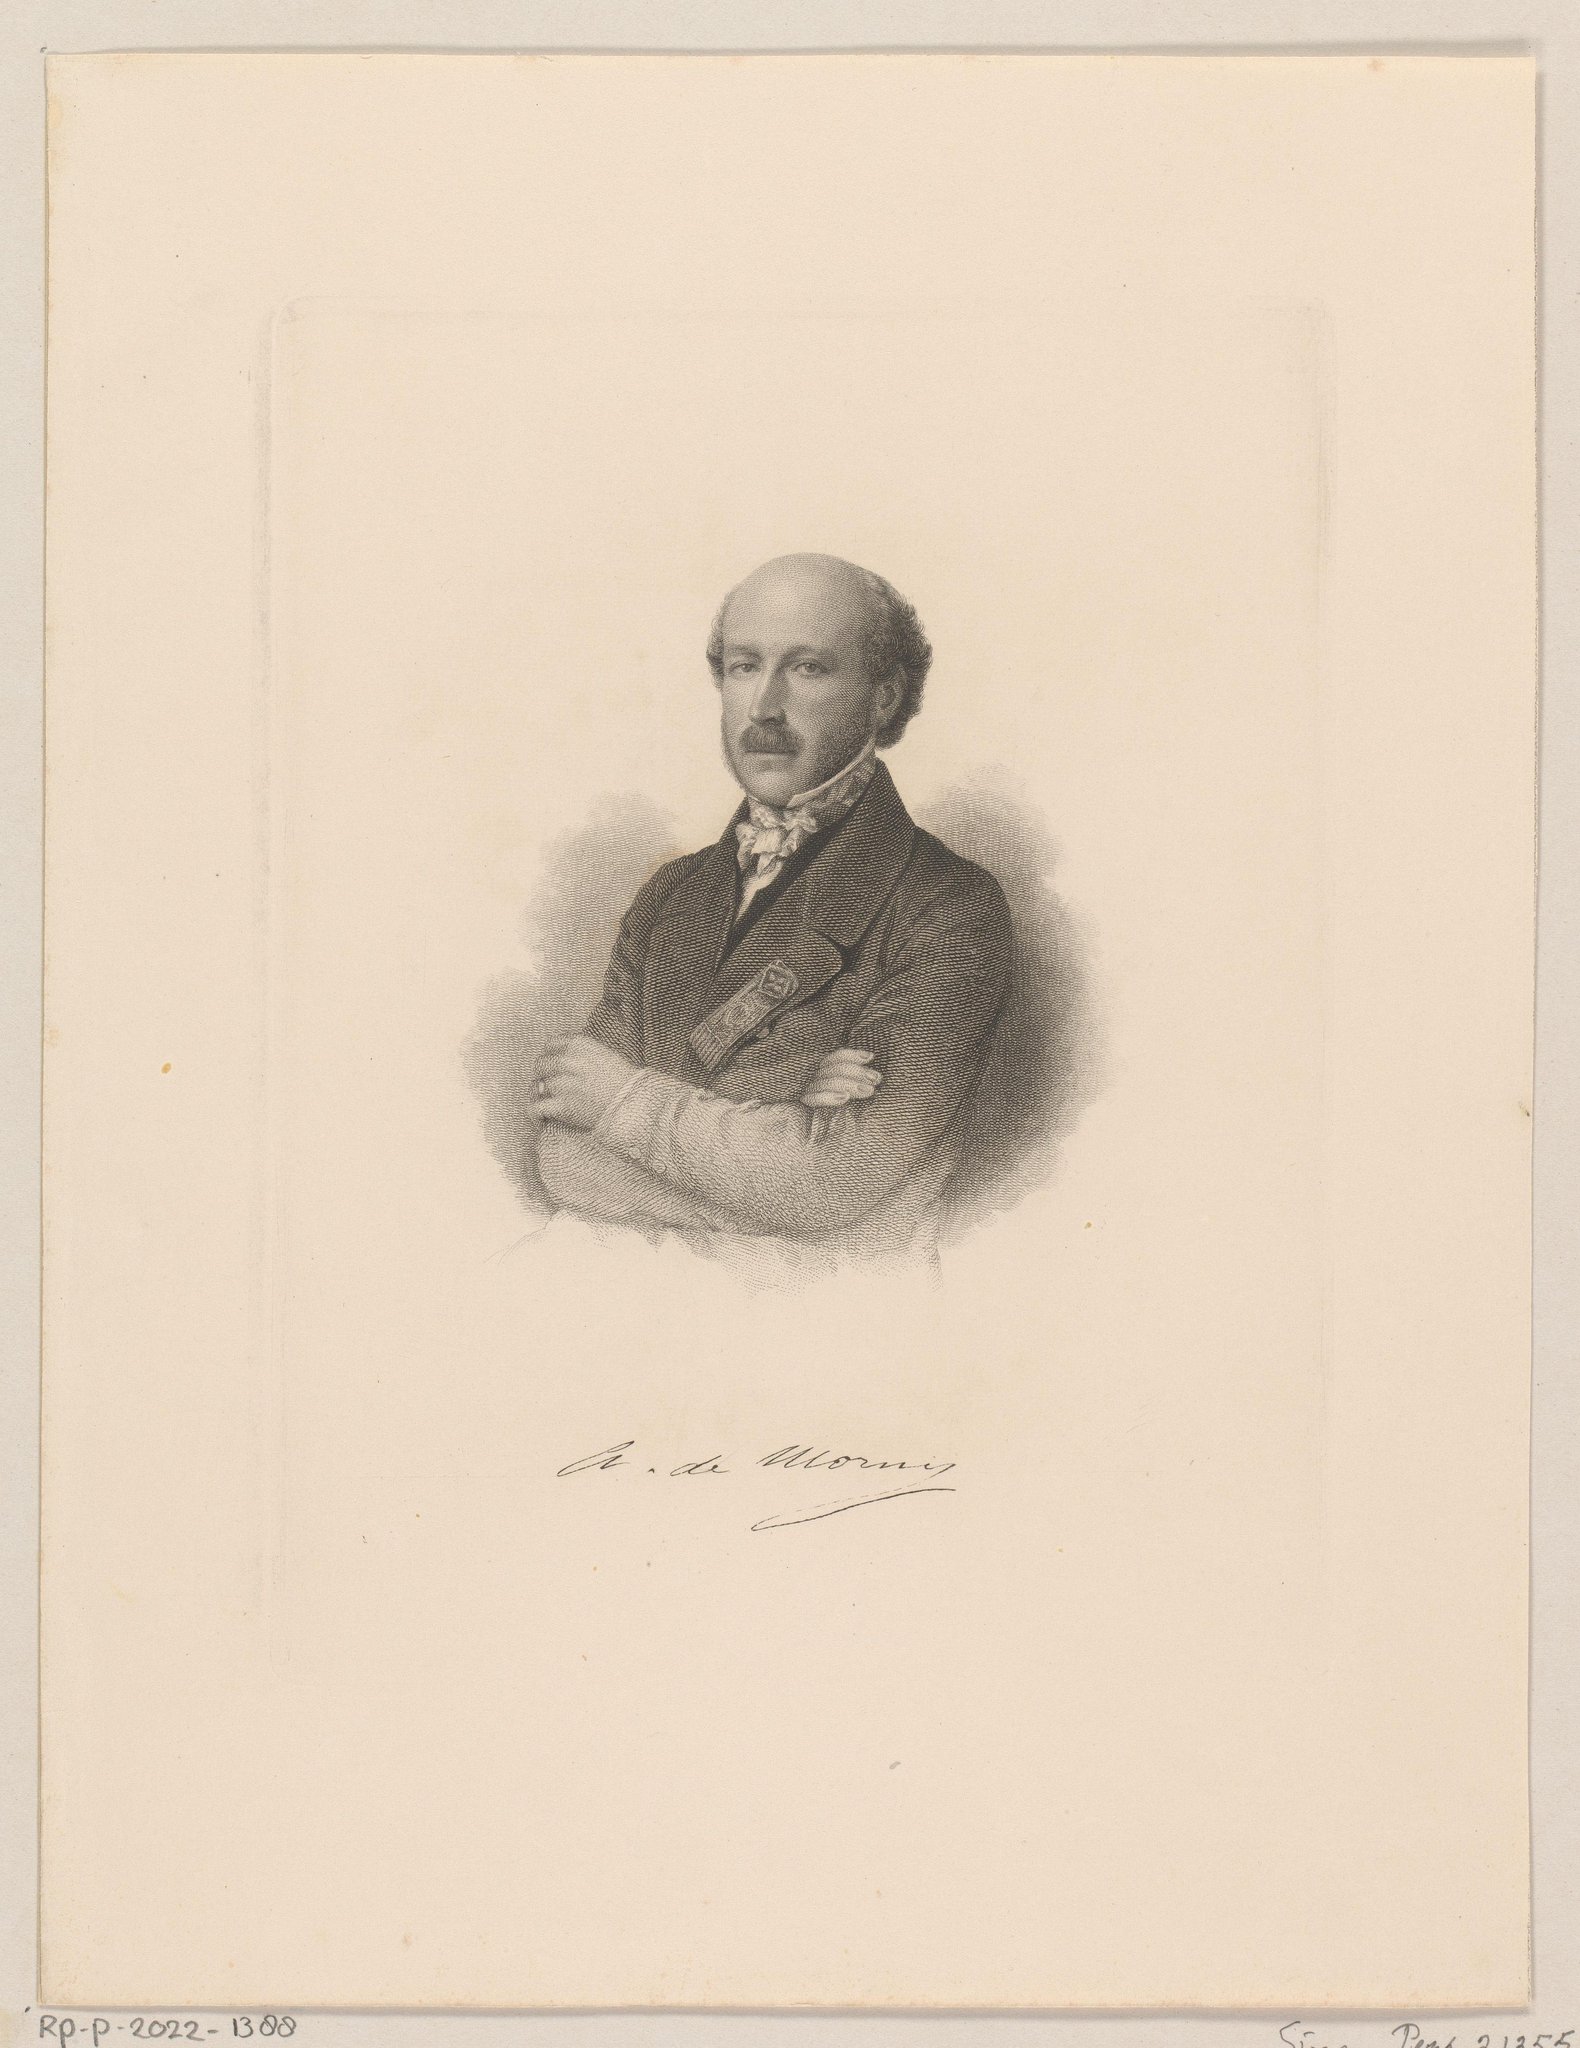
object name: print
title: Portret van Charles hertog de Morny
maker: Anonymous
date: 1842-1900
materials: paper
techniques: engraving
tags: paris, politician, historical persons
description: Met facsimile signatuur van de geportretteerde.